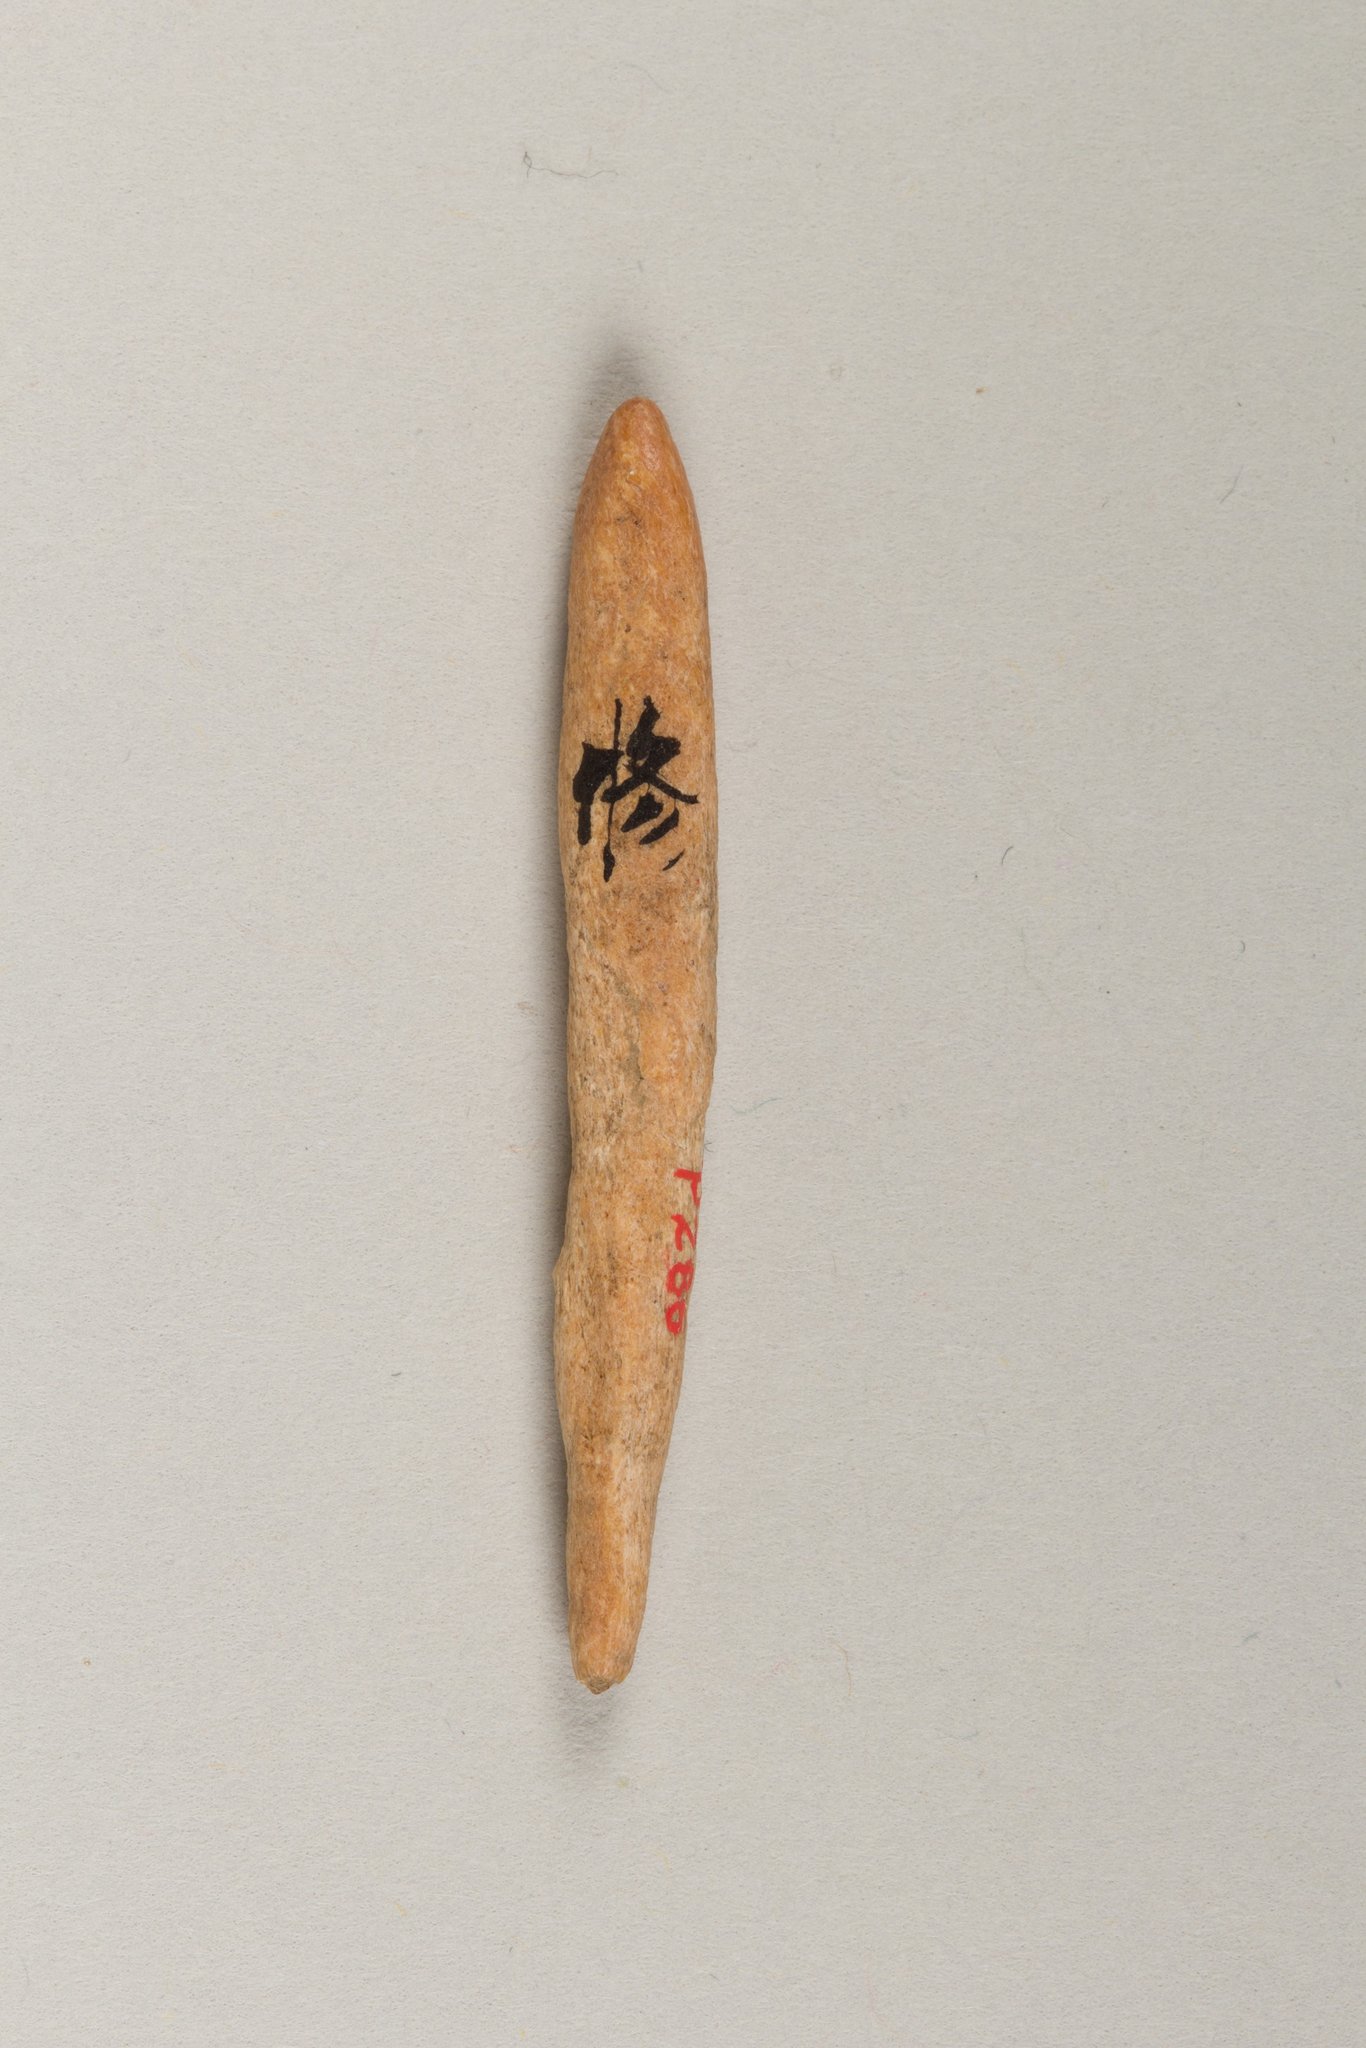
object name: harpoon head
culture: japanese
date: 1000-300 BCE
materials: bone